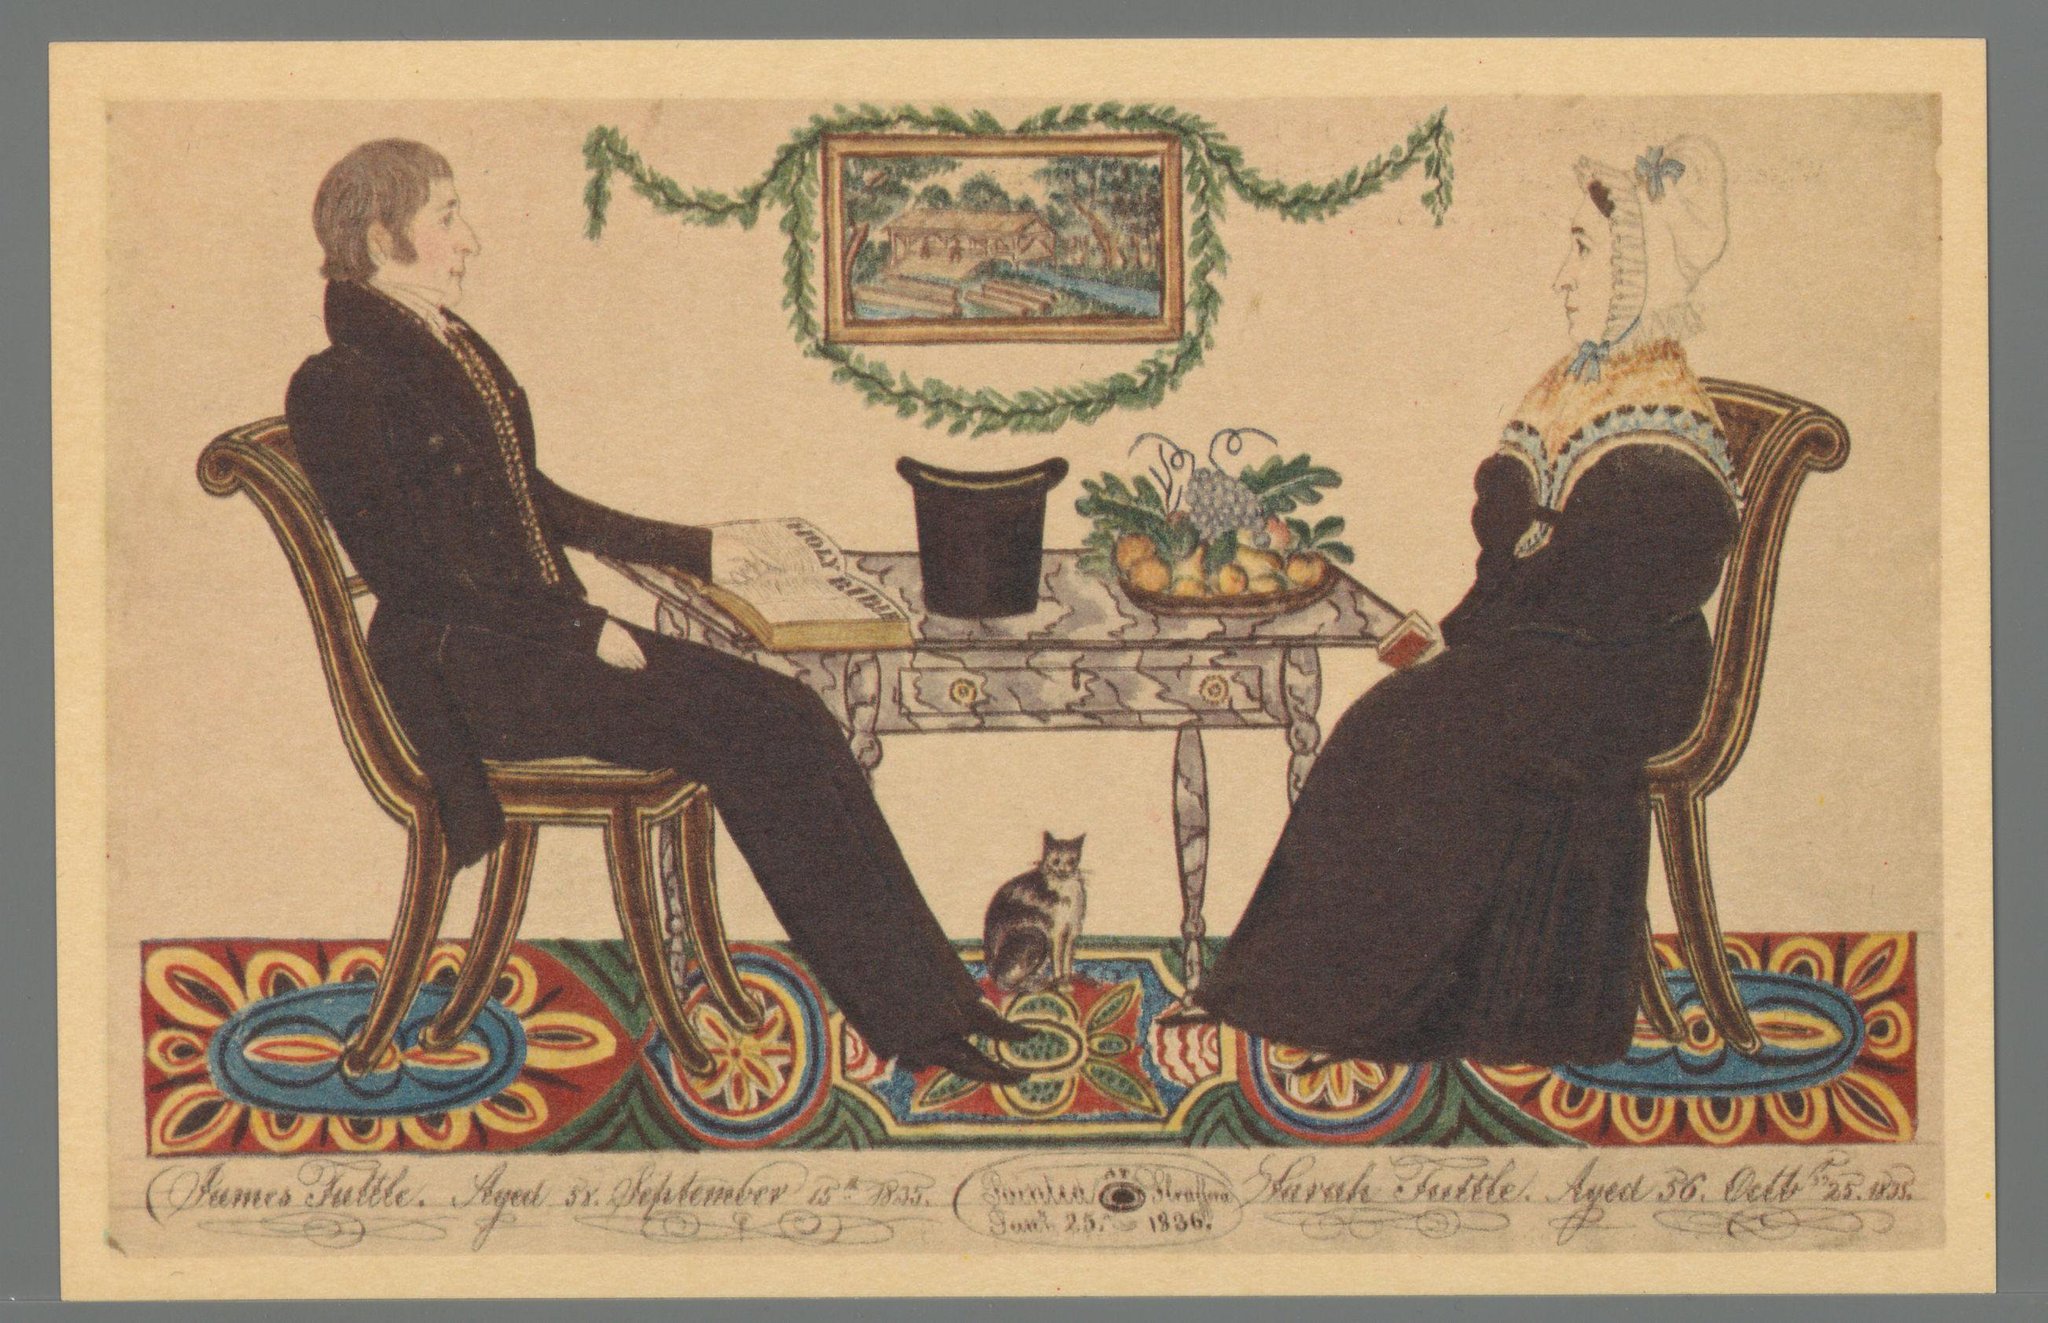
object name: ansichtkaart, prentbriefkaart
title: James and Sarah Tuttle, 1836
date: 1937-1940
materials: cardboard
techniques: photograph, lithograph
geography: new york city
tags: drawing-room, 'salon', cat, marriage, married couple, 'matrimonium'